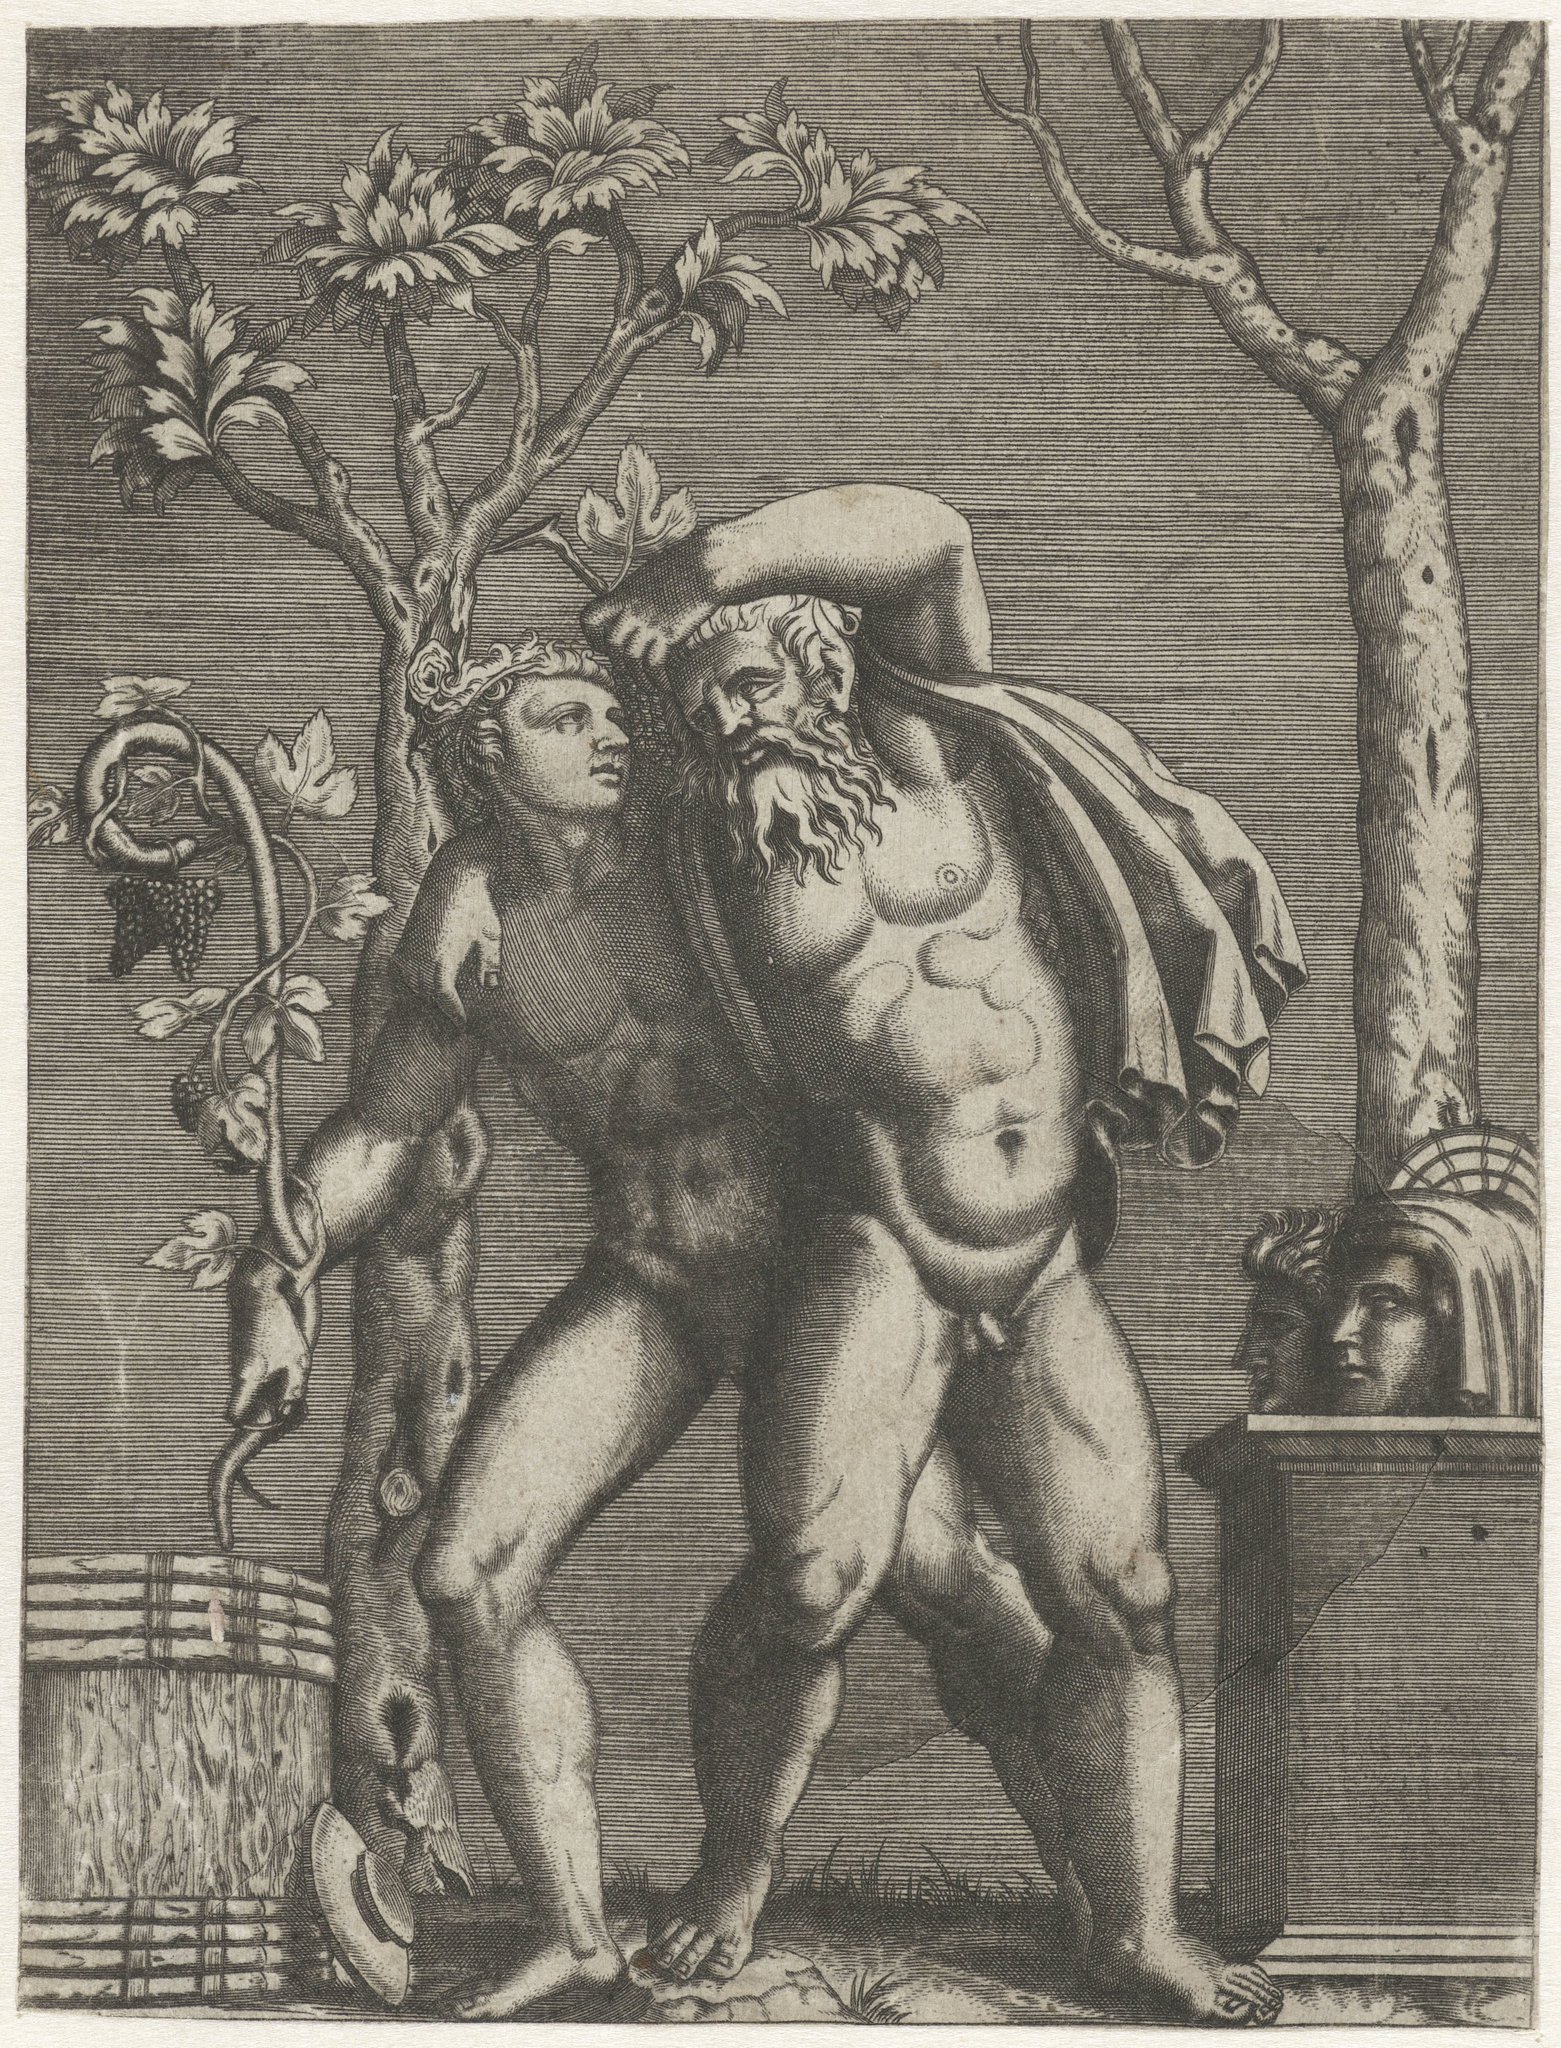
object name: print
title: Silenus ondersteund door een jonge bacchant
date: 1520-1575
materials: paper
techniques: engraving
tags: male bacchant(es), (story of) silenus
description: Dronken Silenus wordt ondersteund door een bacchant. Beiden houden druivenranken vast. Links naast hen staan een wijnvat waartegen een omgekeerde drinkschaal leunt.